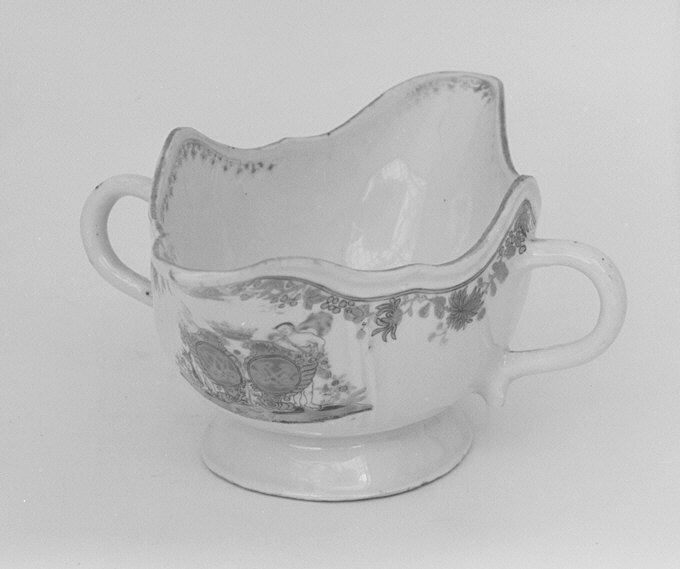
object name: gravy boat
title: Gravy boat (part of a service)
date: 1760-1770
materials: hard paste porcelain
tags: men,flowers